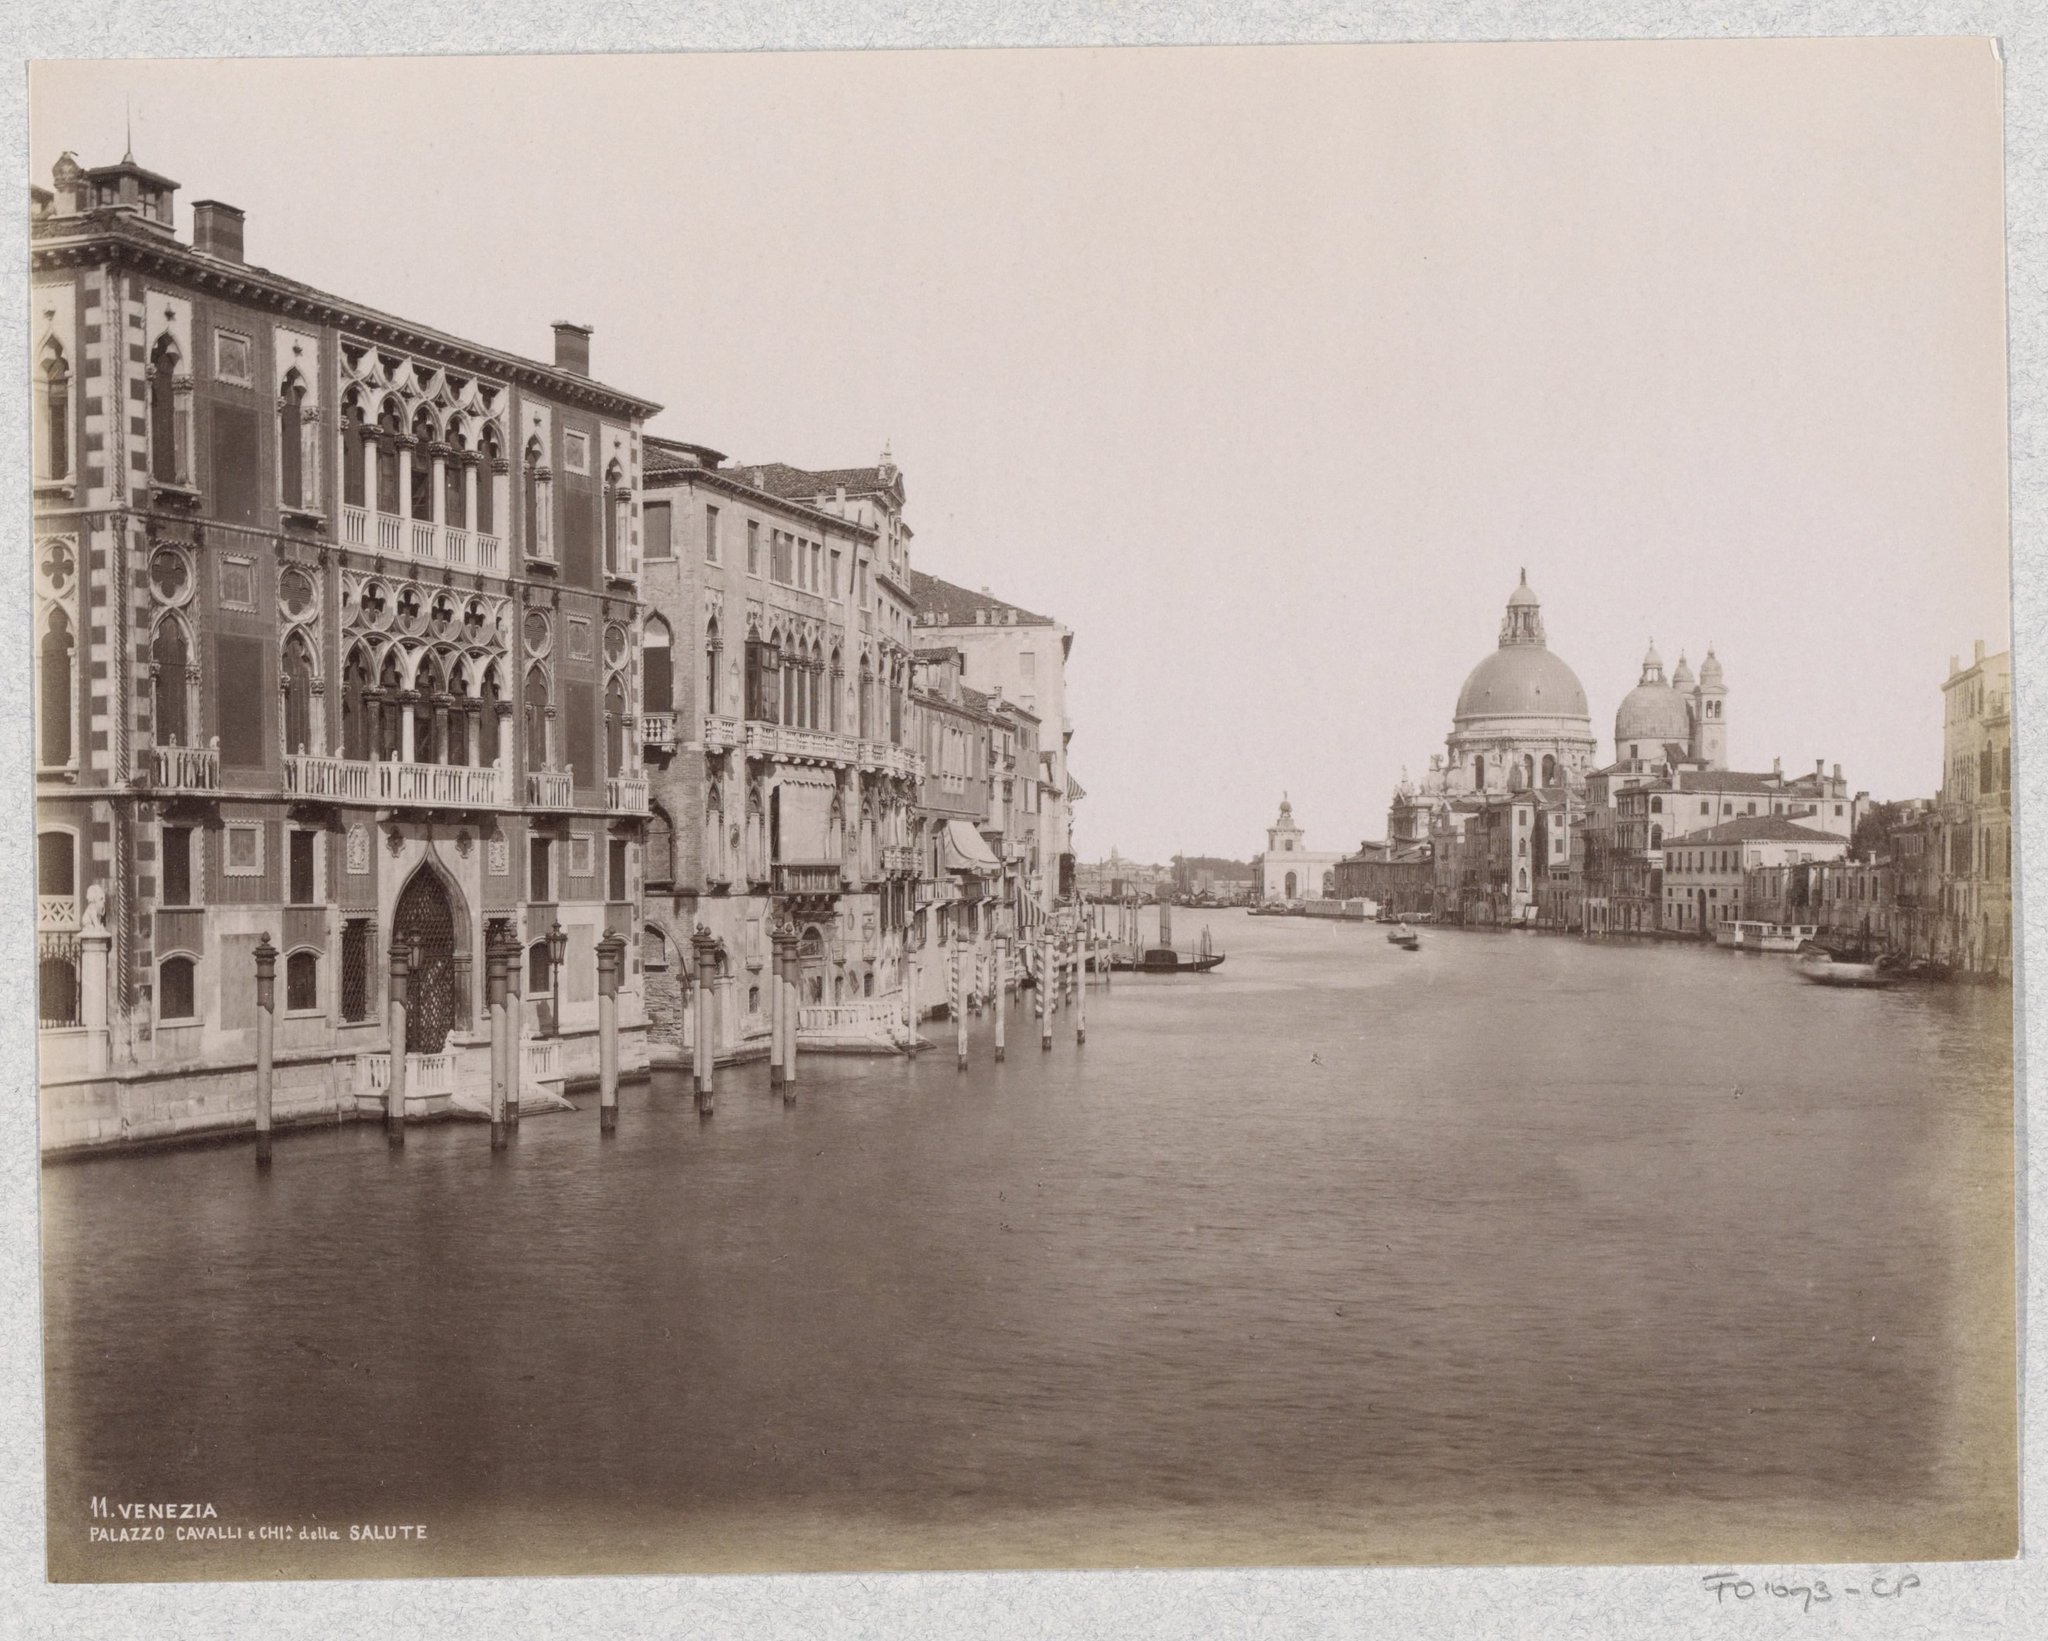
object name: photograph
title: Venezia Palazzo Cavalli e Chia della Salute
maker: Anonymous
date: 1870-1890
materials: paper, photographic support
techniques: albumen print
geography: venice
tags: canal, palace, church (exterior), venice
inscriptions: negative number: ‘11’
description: Onderdeel van Reisalbum met foto's van bezienswaardigheden in Genua, Florence en Venetië.